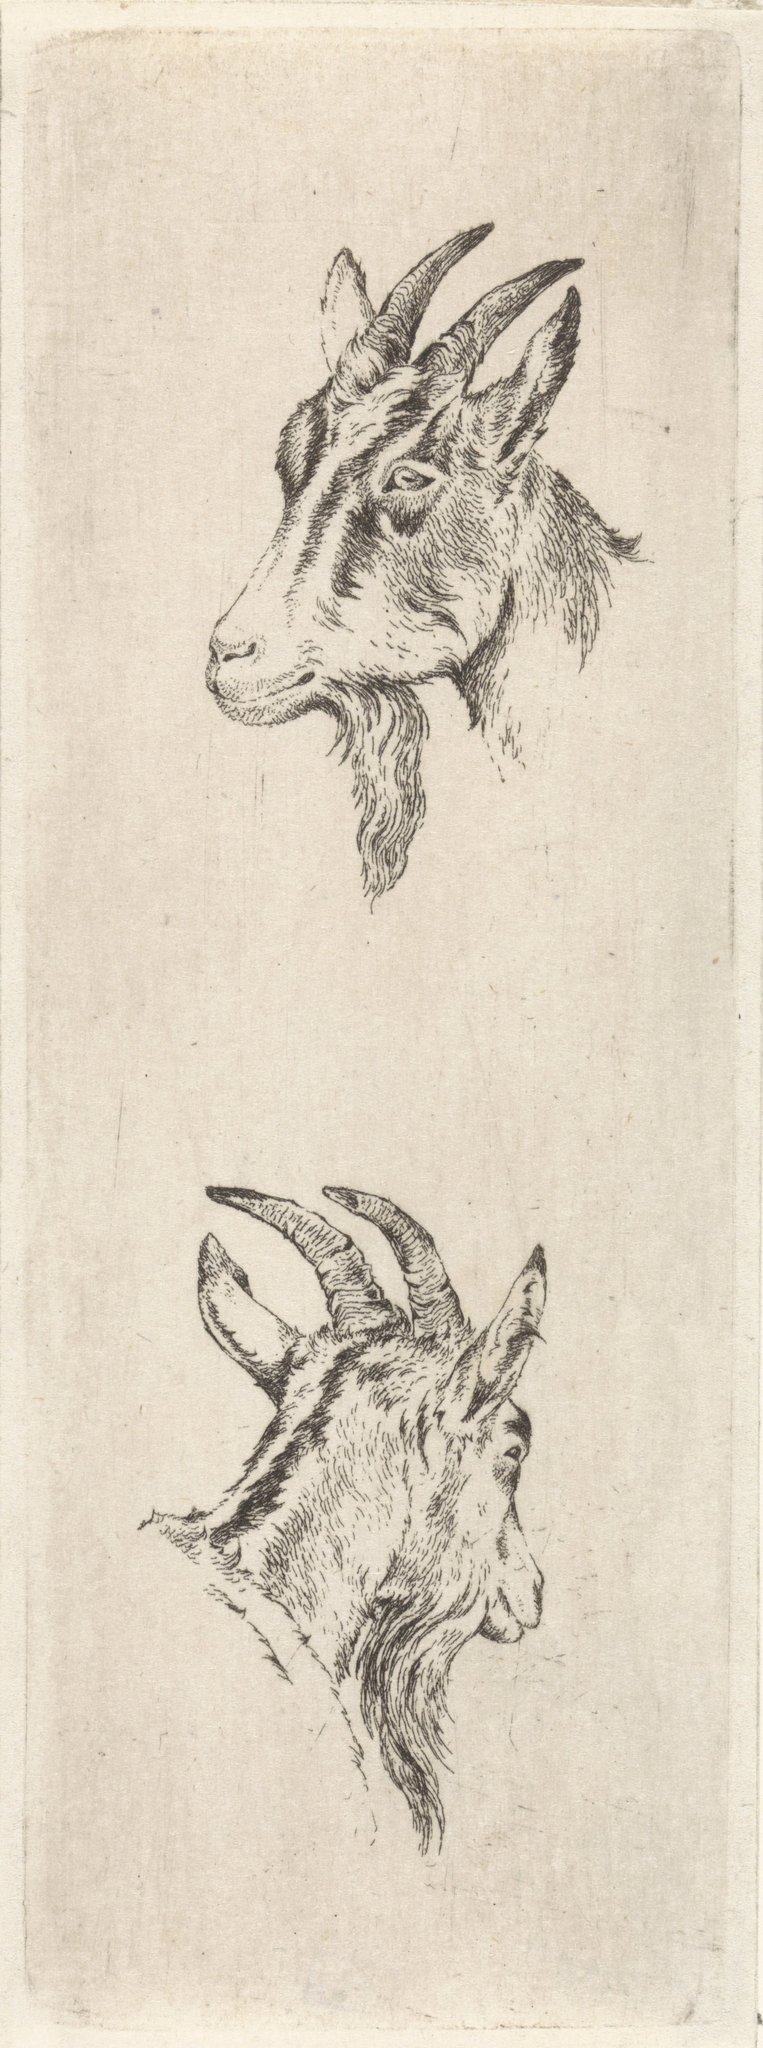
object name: print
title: Bokkenkop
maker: pieter janson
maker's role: draughtsman, print maker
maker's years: 1765-1851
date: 1780-1851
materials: paper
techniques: etching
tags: he-goat, billy-goat (+ male animal)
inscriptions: collector's mark: Lugt 2227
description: Kop van een bok naar links en daaronder kop van een bok naar rechts, van achter gezien. Vóór de randlijnen.